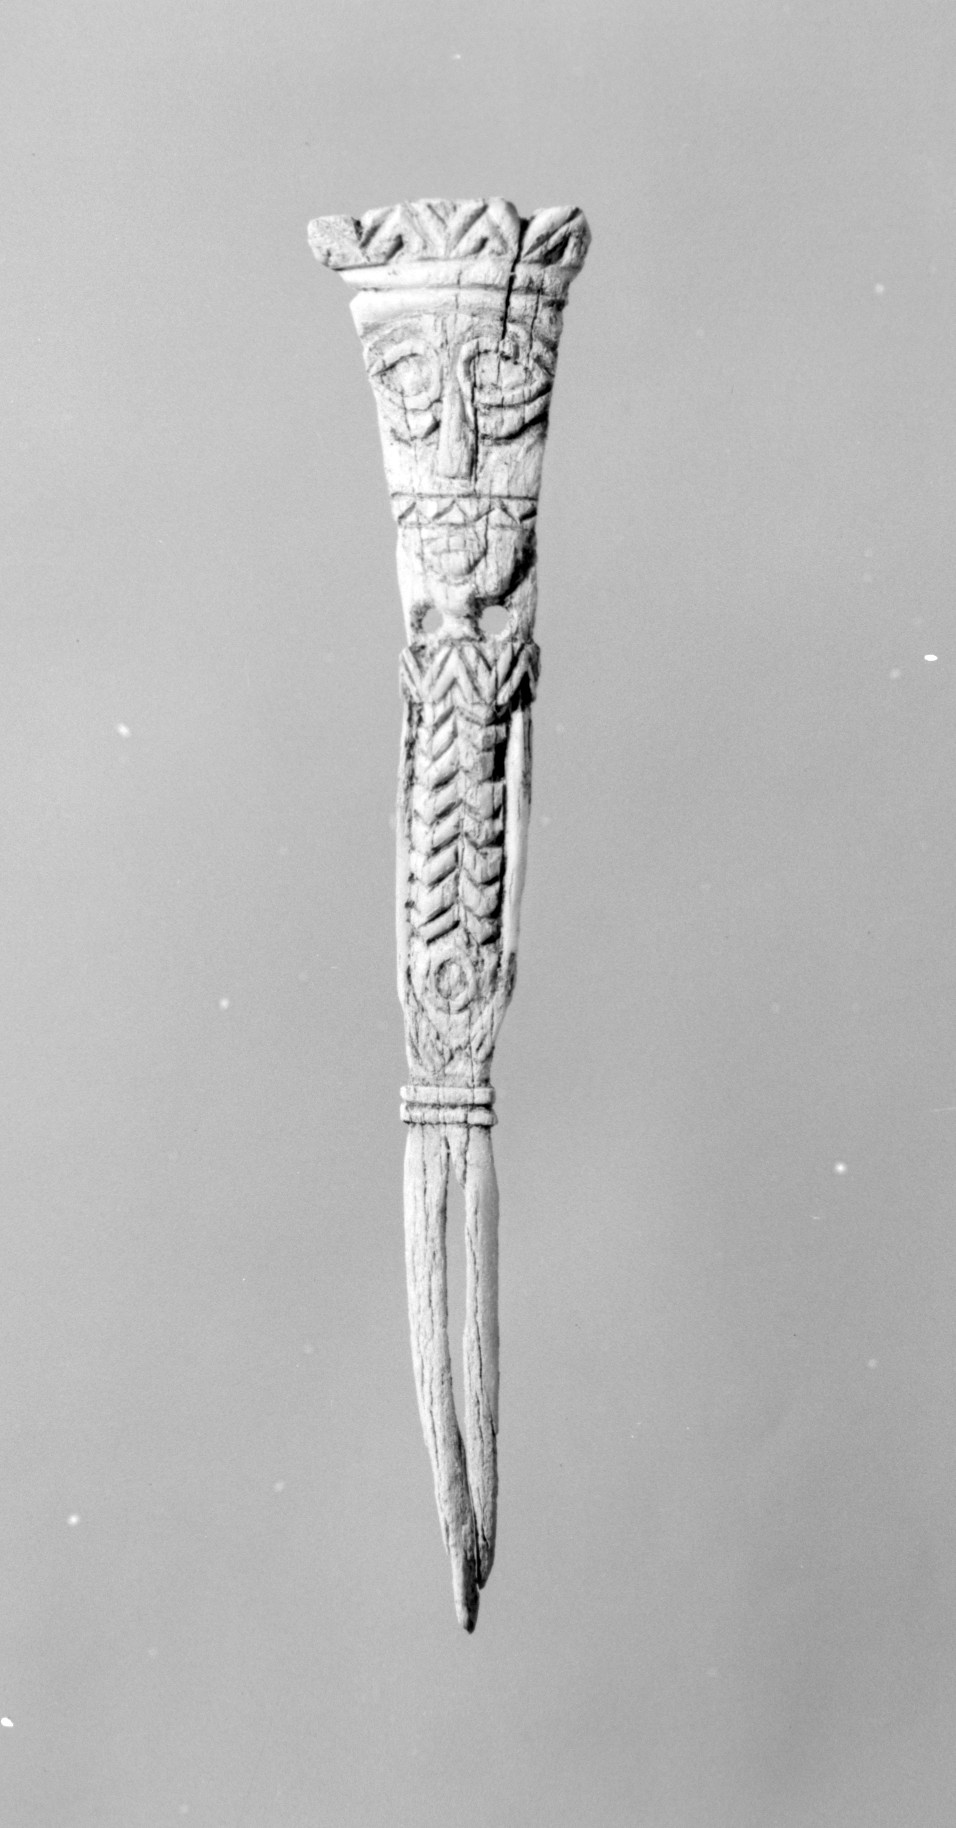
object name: figure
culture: columbia river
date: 1701-1800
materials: bone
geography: united states